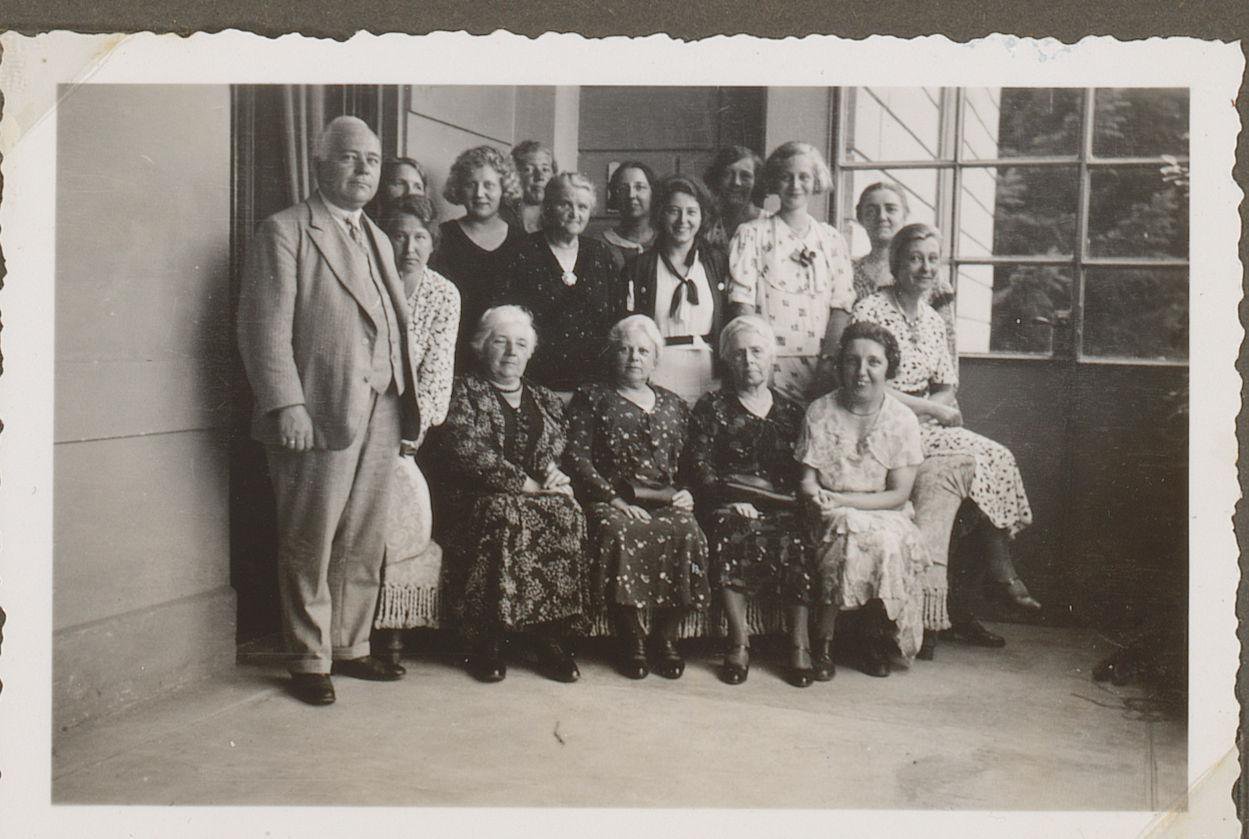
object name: album leaf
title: Gasten in de waranda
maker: Anonymous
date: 1934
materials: photographic support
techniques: gelatin silver print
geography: tesserete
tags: historical persons